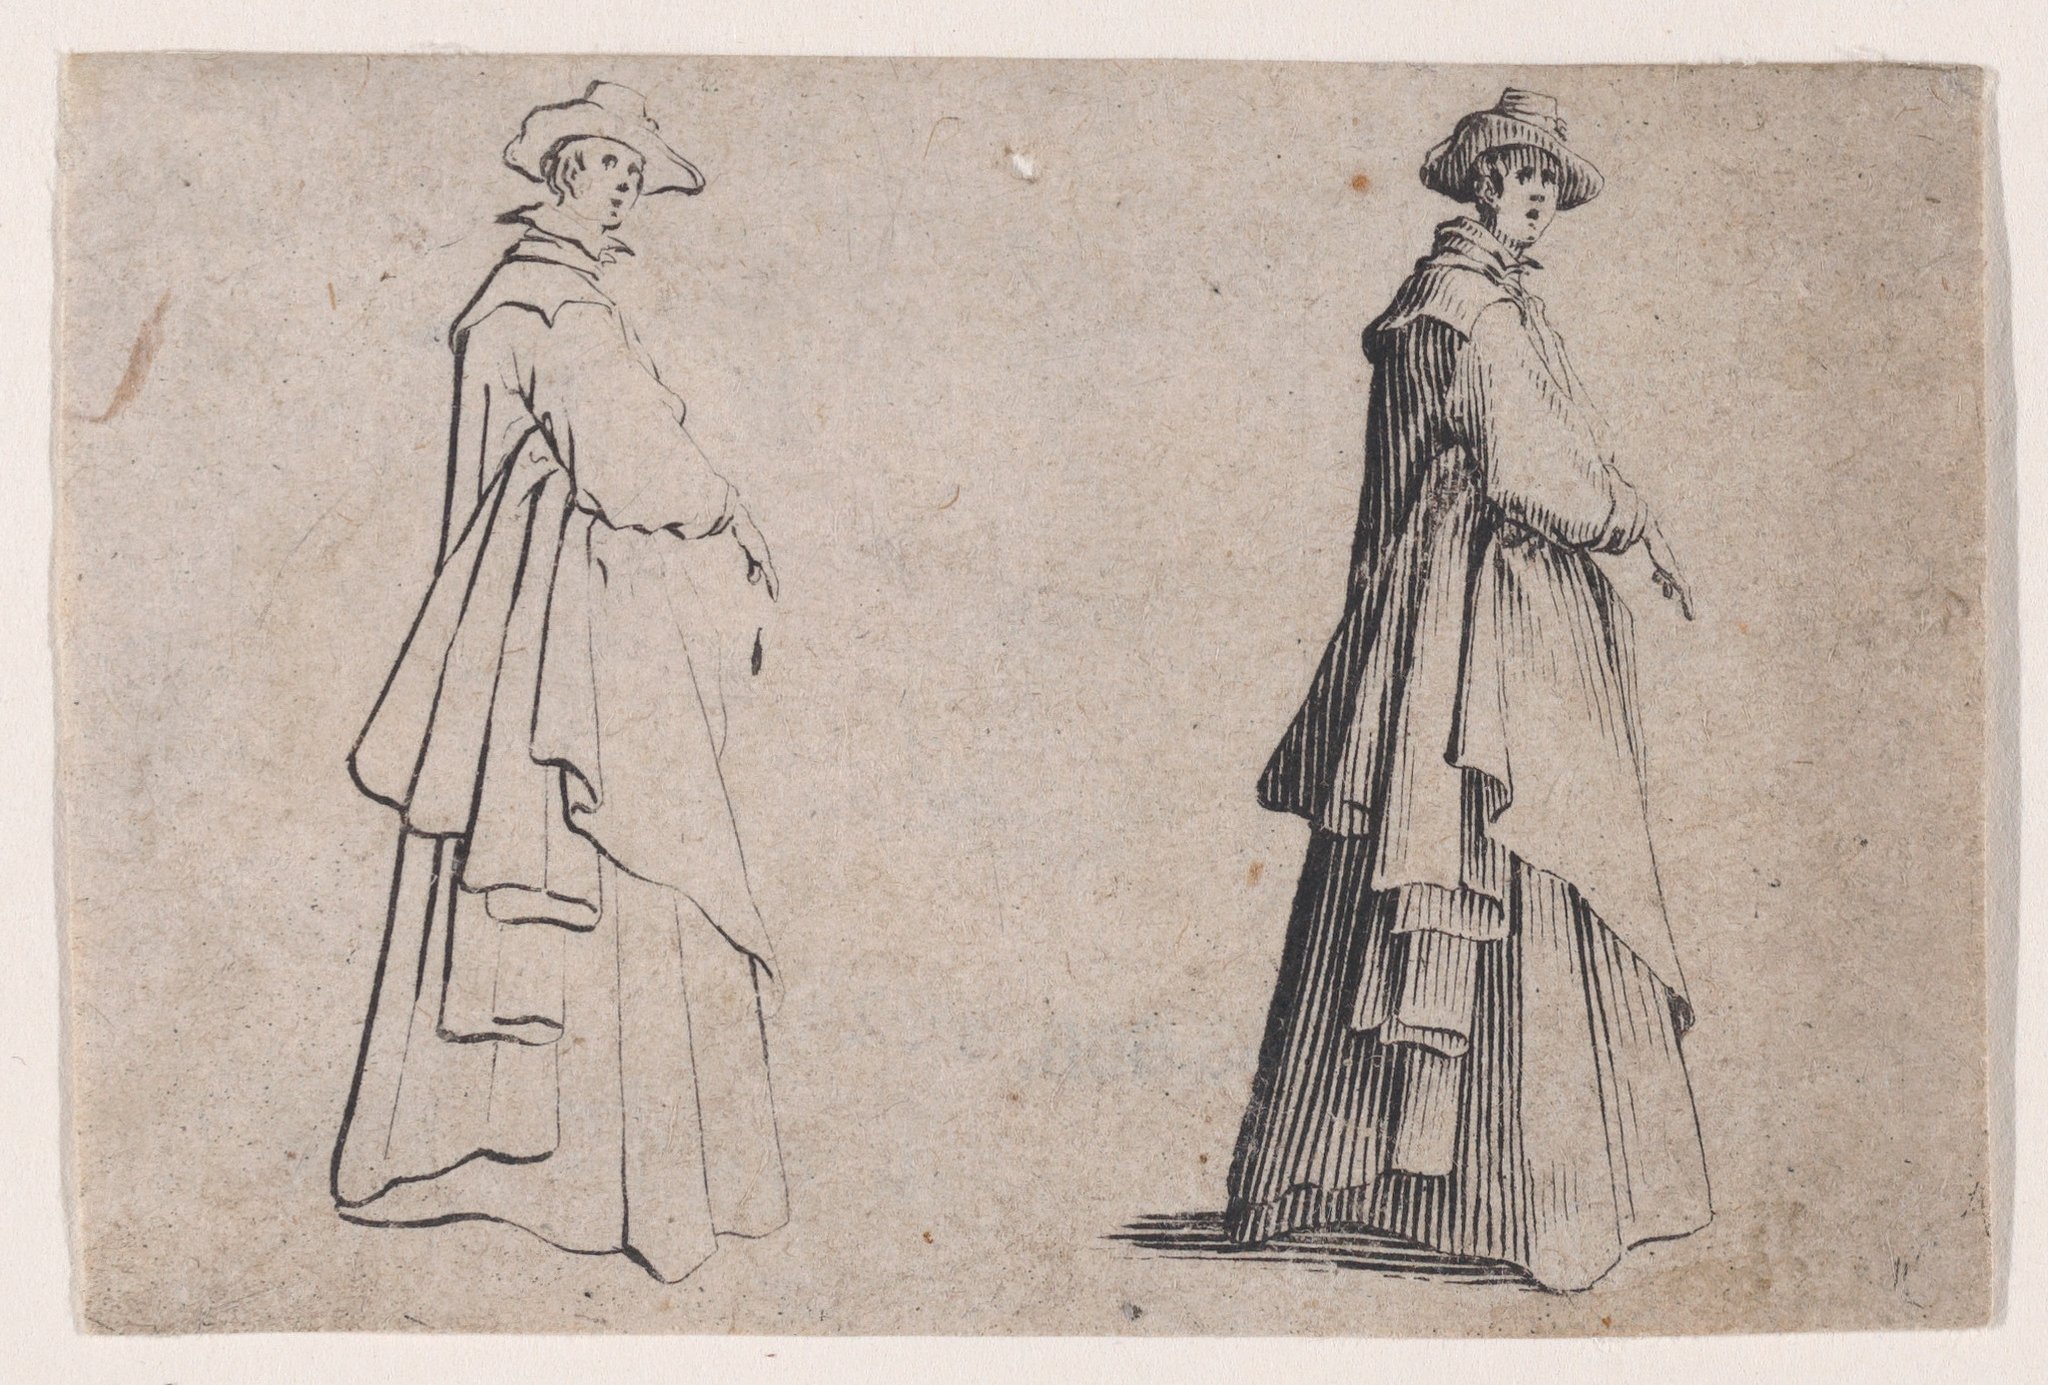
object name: print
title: La Dame au Vêtement Ample (The Woman with Ample Clothing), from Les Caprices Series B, The Nancy Set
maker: jacques callot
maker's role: artist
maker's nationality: french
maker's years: 1592-1635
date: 1617-1620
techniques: etching